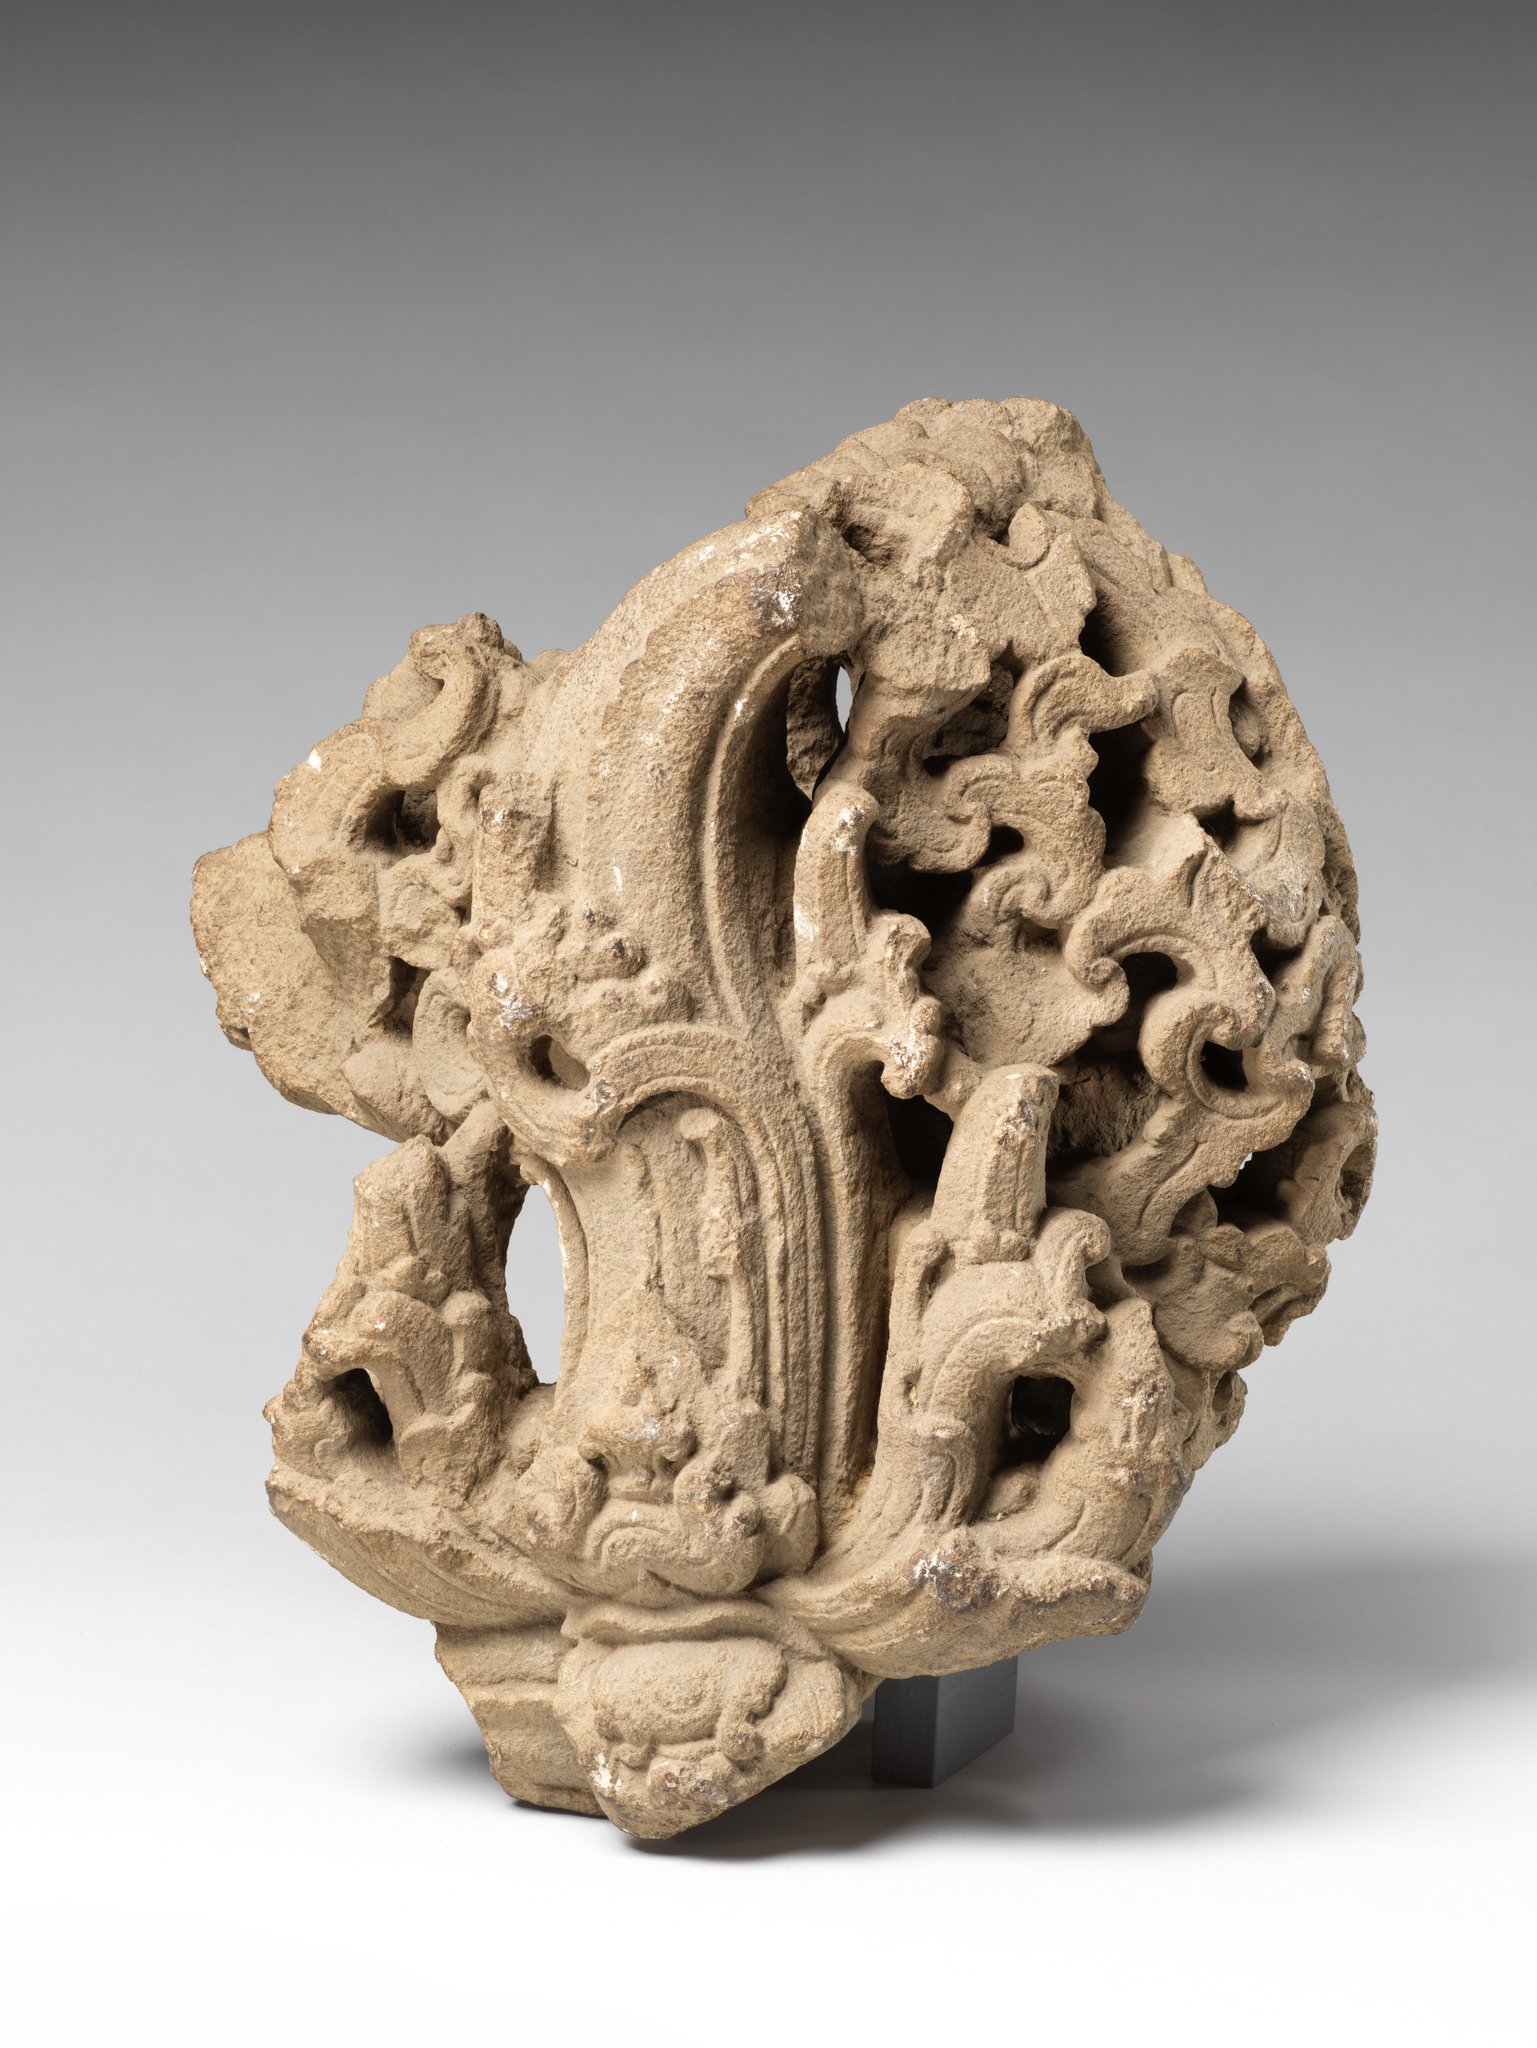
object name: water spout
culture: indonesian, javanese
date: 901-1000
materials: stone